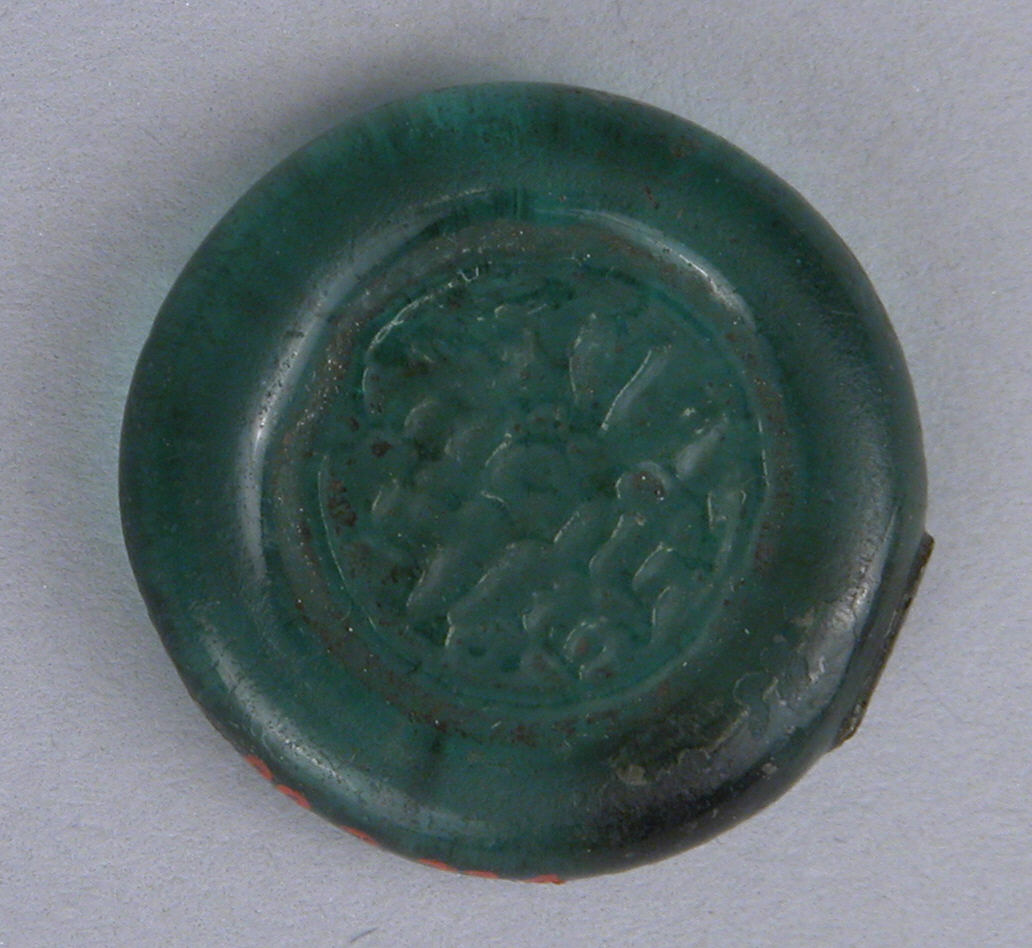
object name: coin weight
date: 901-1200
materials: glass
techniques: stamping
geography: egypt